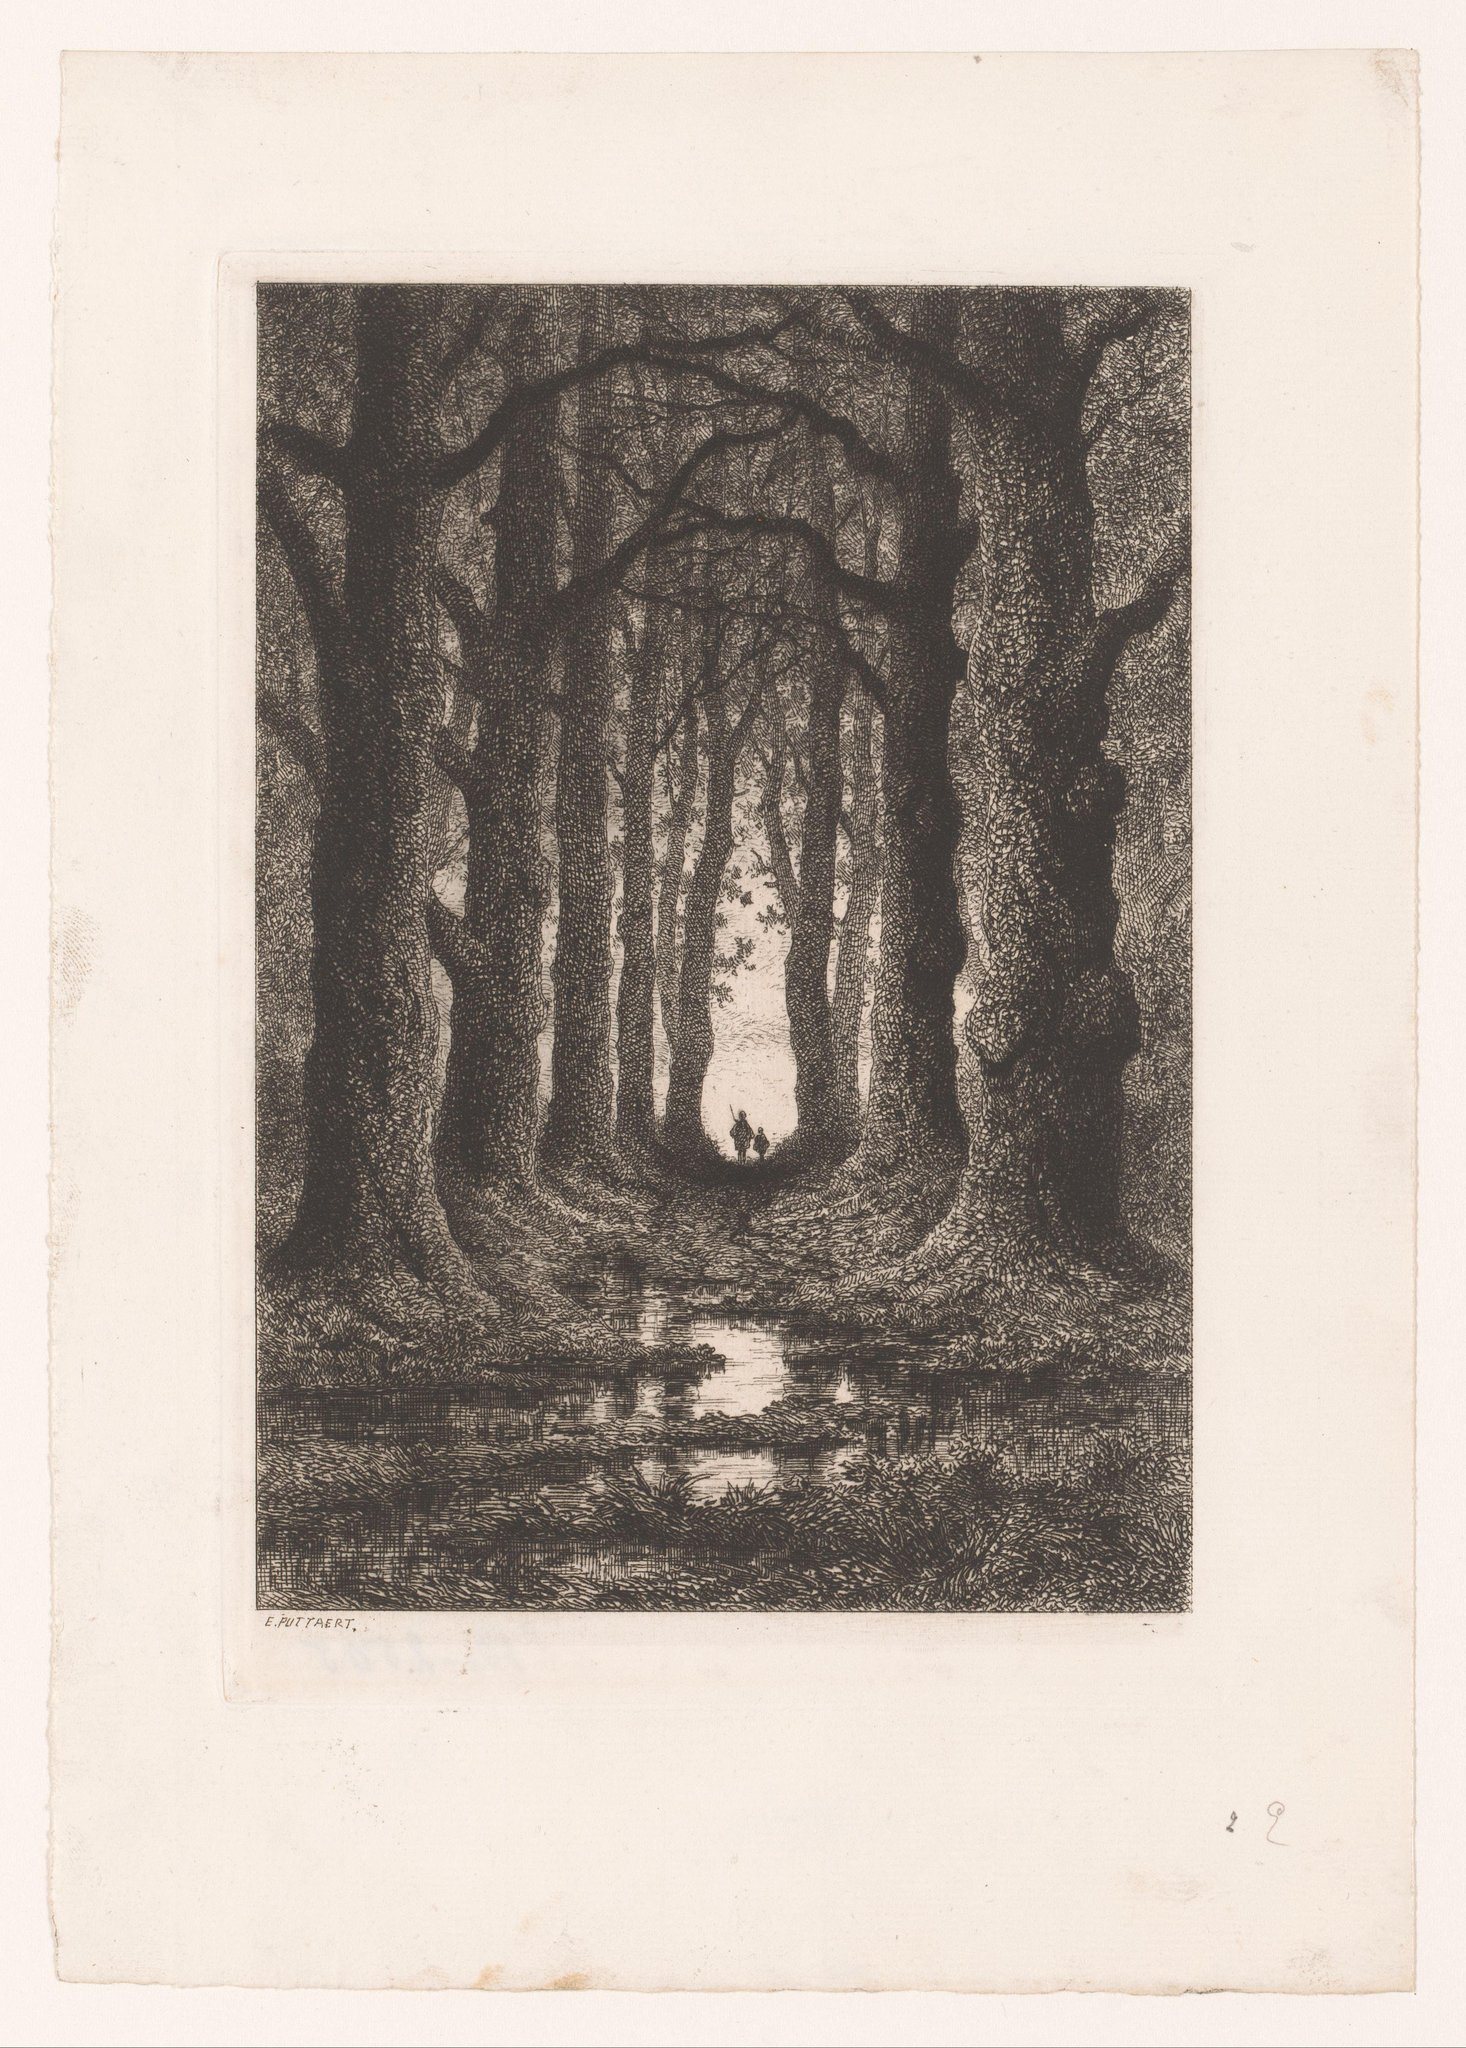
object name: print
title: Twee figuren lopen met zonsondergang in het Zoniënwoud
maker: emile puttaert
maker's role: print maker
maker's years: 1829-1901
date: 1839-1875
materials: paper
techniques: drypoint, etching, intaglio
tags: landscapes with waters, waterscapes, seascapes (in the temperate zone), forest, wood (+ landscape with figures, staffage)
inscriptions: collector's mark: Lugt 2228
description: Latere staat met ondertitel verschenen in: Album d'eaux-fortes originales et inédites. Brussel: Félix Callewaert, 1875.